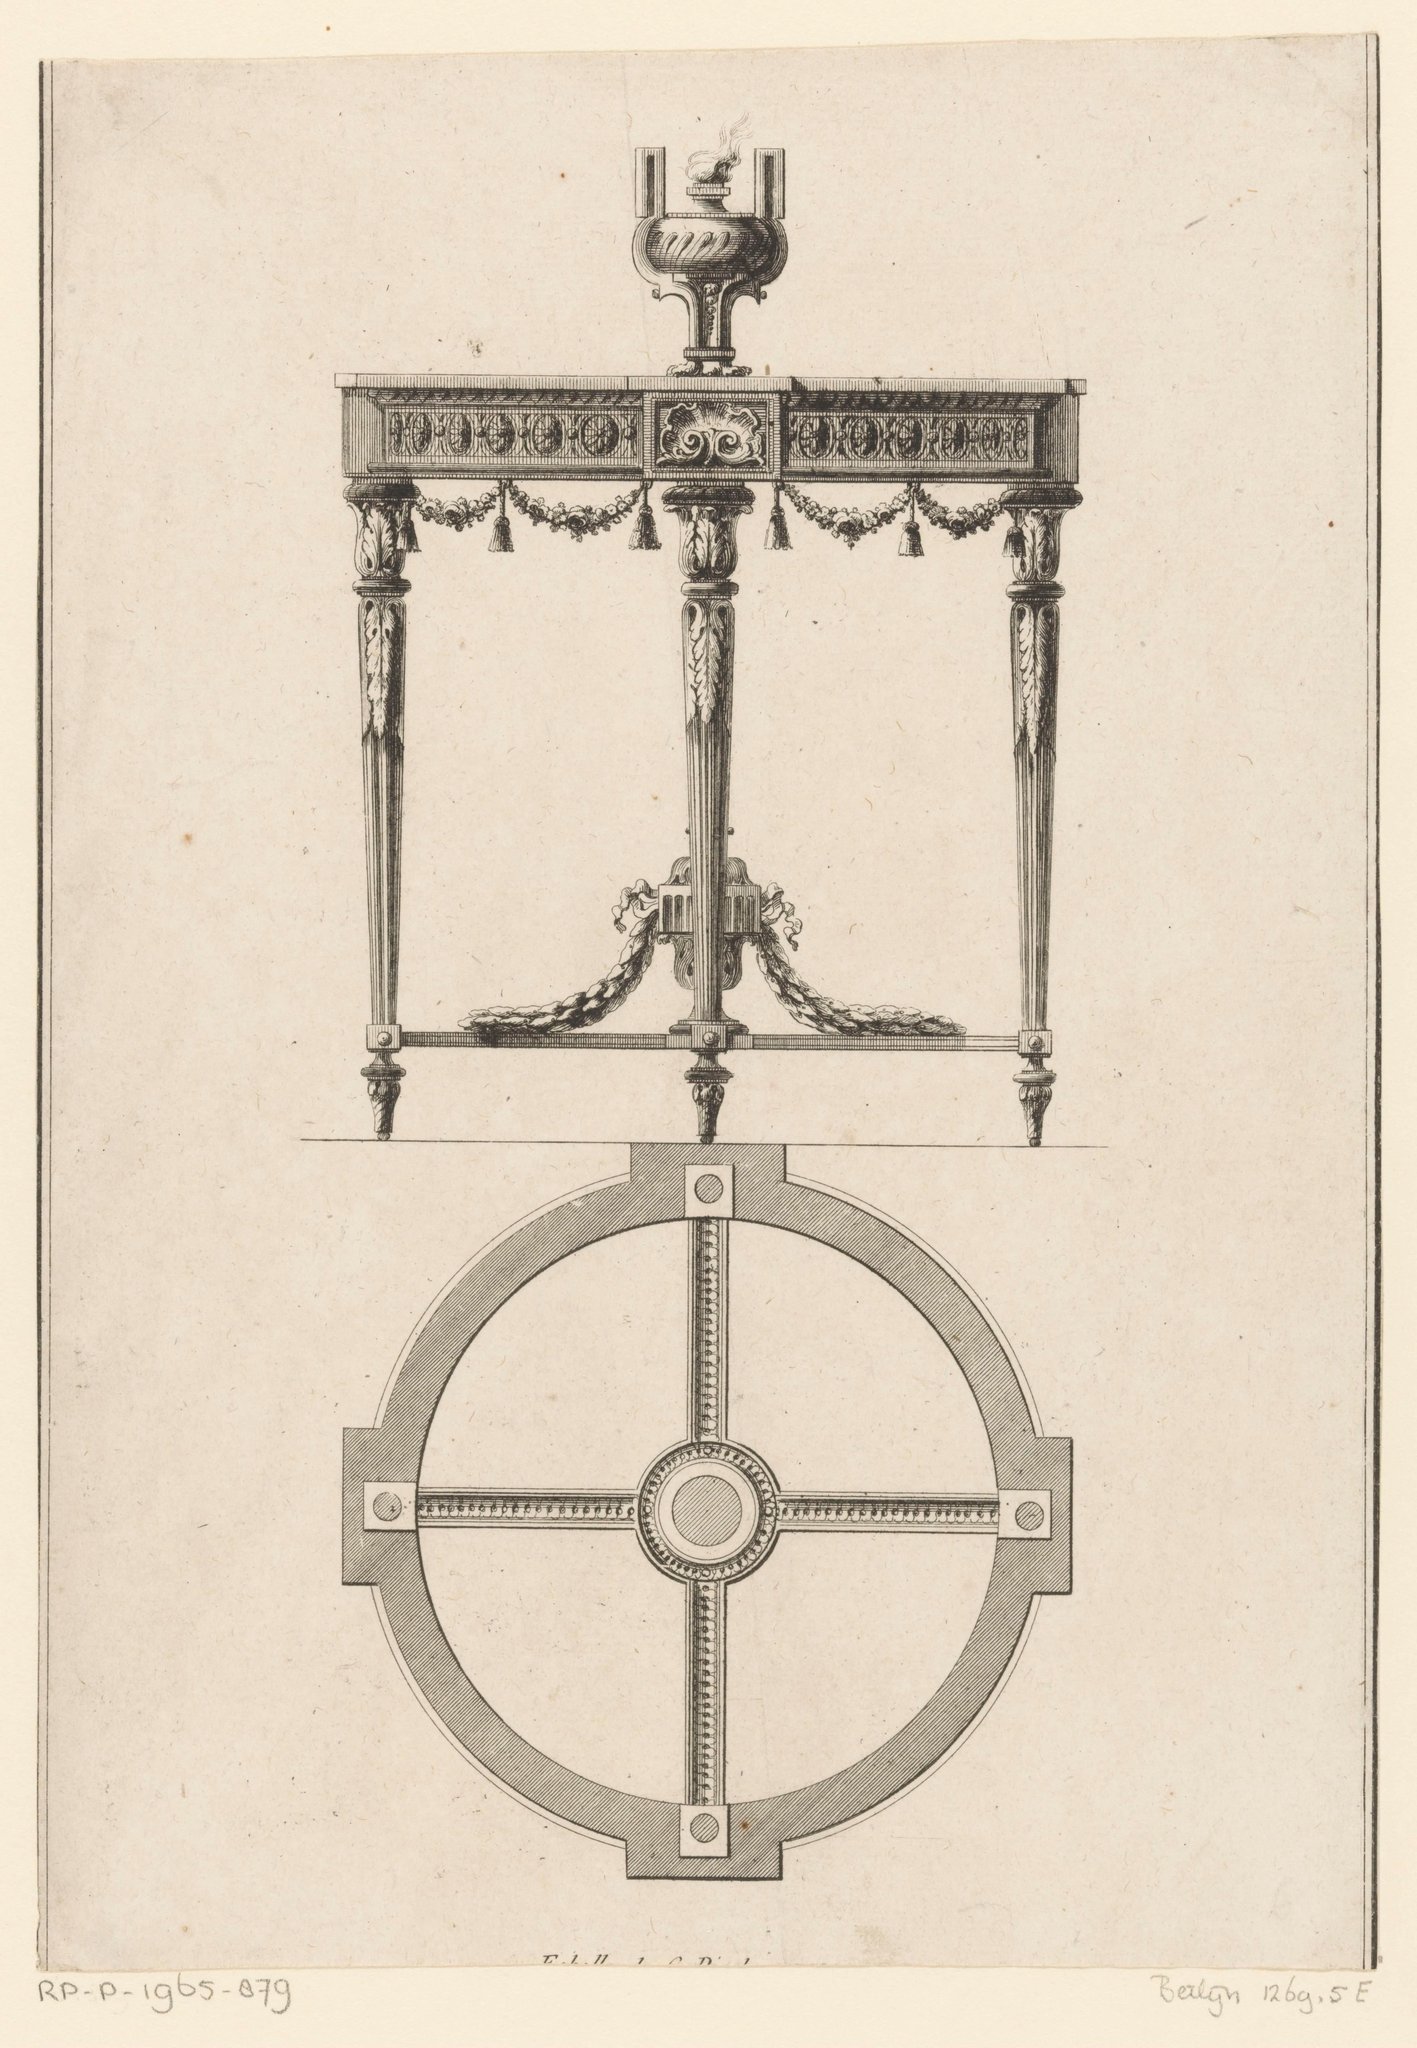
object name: ornament print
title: Ronde tafel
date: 1784-1785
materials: paper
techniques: engraving, etching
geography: paris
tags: table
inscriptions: collector's mark: Lugt 2760, collector's mark: Lugt 2228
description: Voor- en bovenaanzicht van een geornamenteerde tafel met guirlandes en een schelpmotief. Bovenop de tafel staat een rookvat.